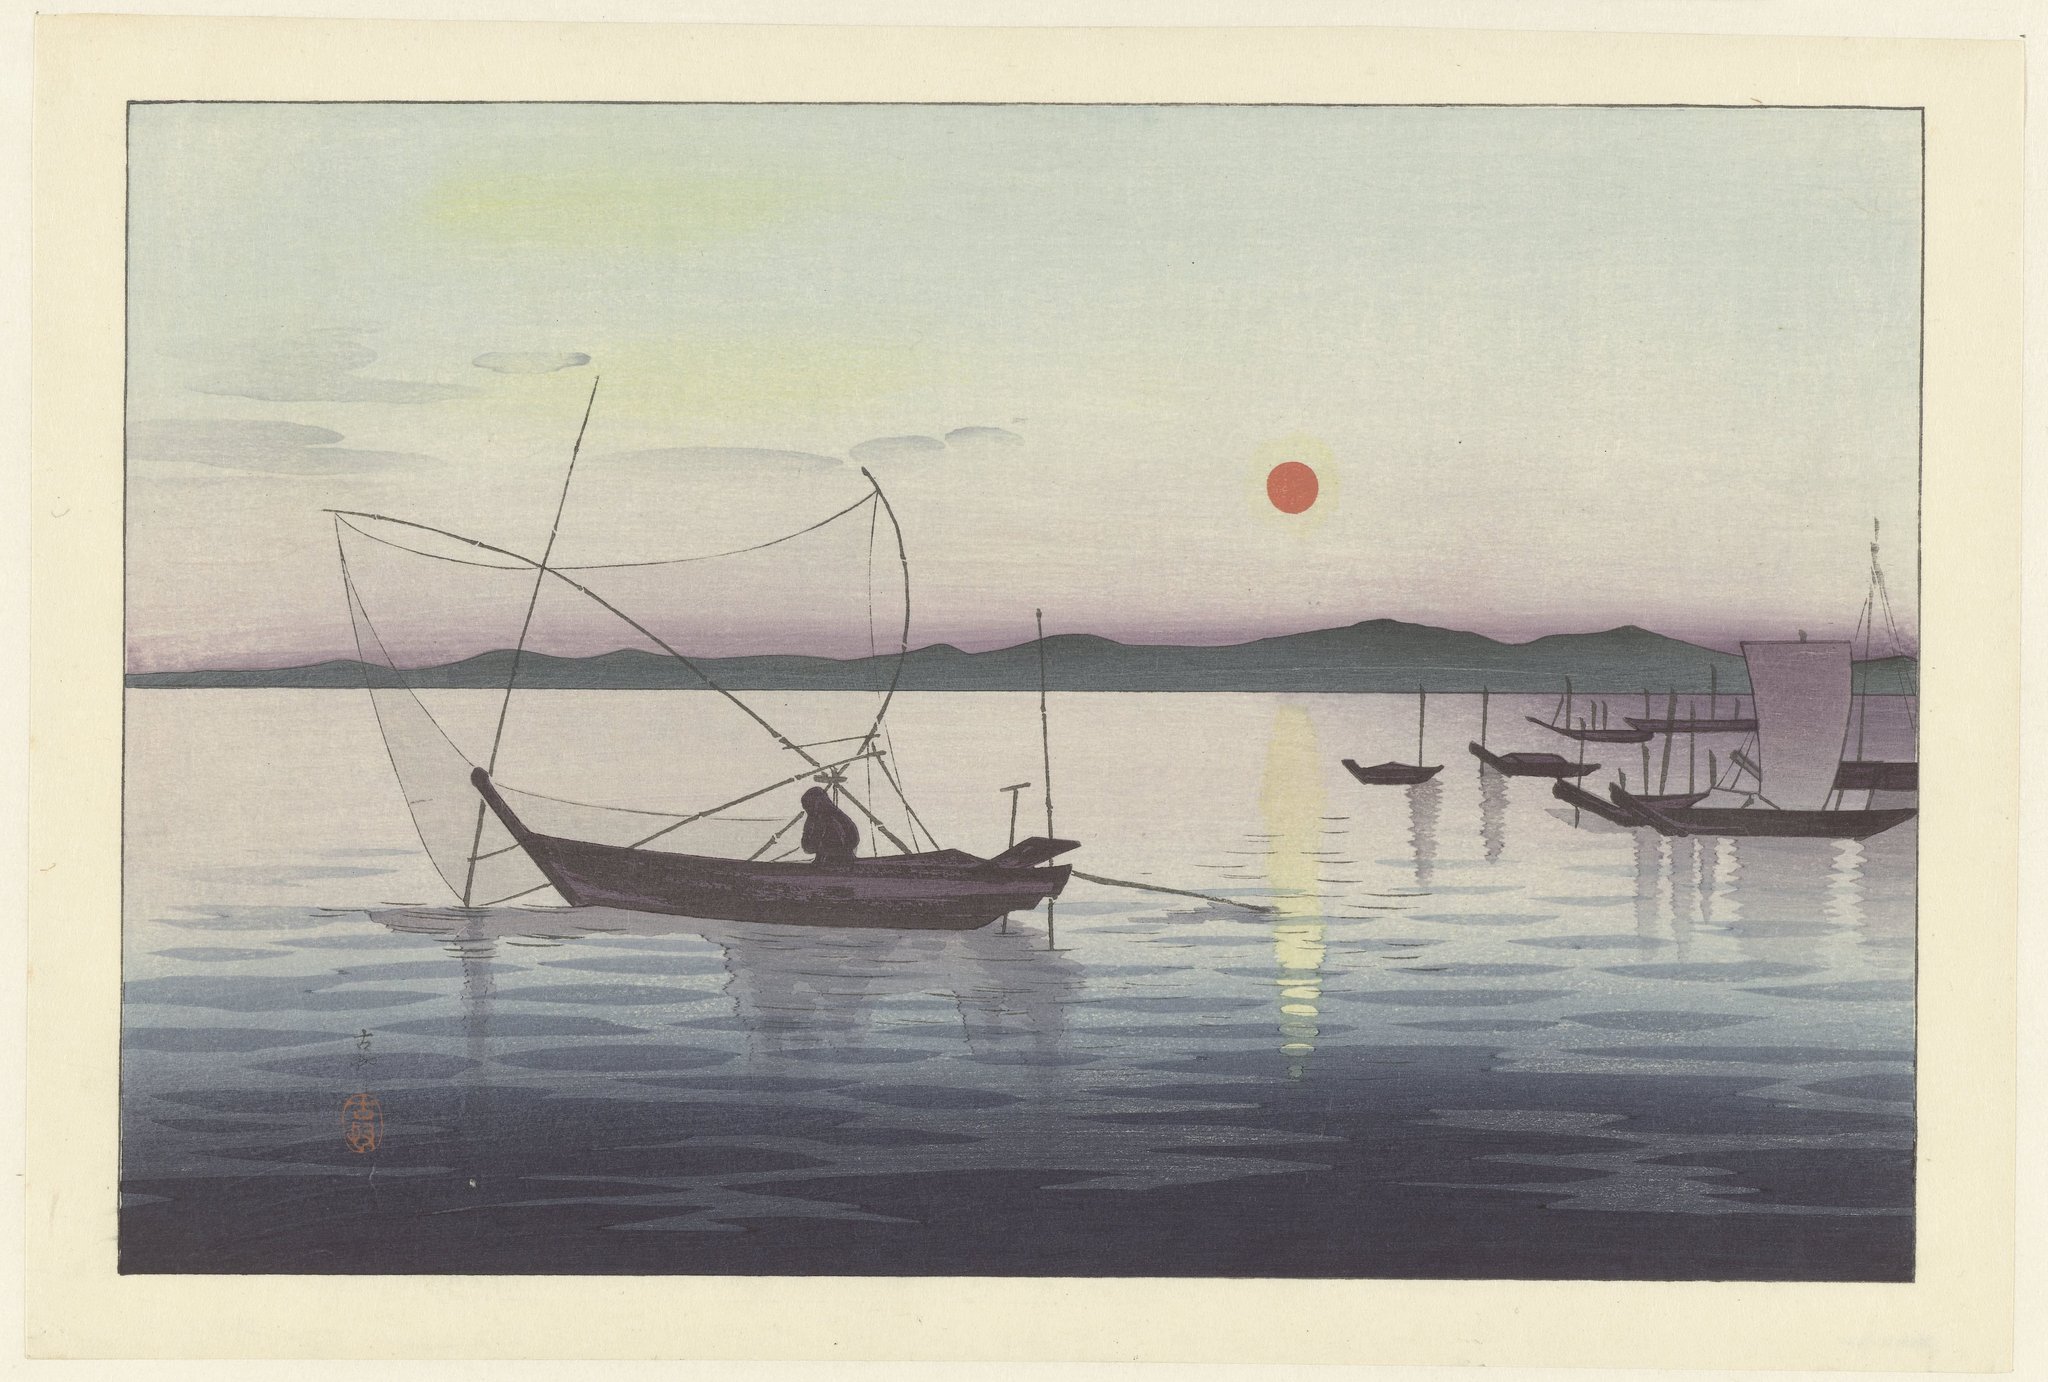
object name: print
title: Boten en ondergaande zon.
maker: ohara koson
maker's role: print maker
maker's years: 1877-1945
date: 1900-1936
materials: paper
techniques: woodcut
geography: japan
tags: sunset, traffic on the water, water course (+ landscape with figures, staffage)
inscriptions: collector's mark: Lugt 2228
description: Boten op het water, waarin de weerspiegeling van de oranje ondergaande zon boven de bergen.